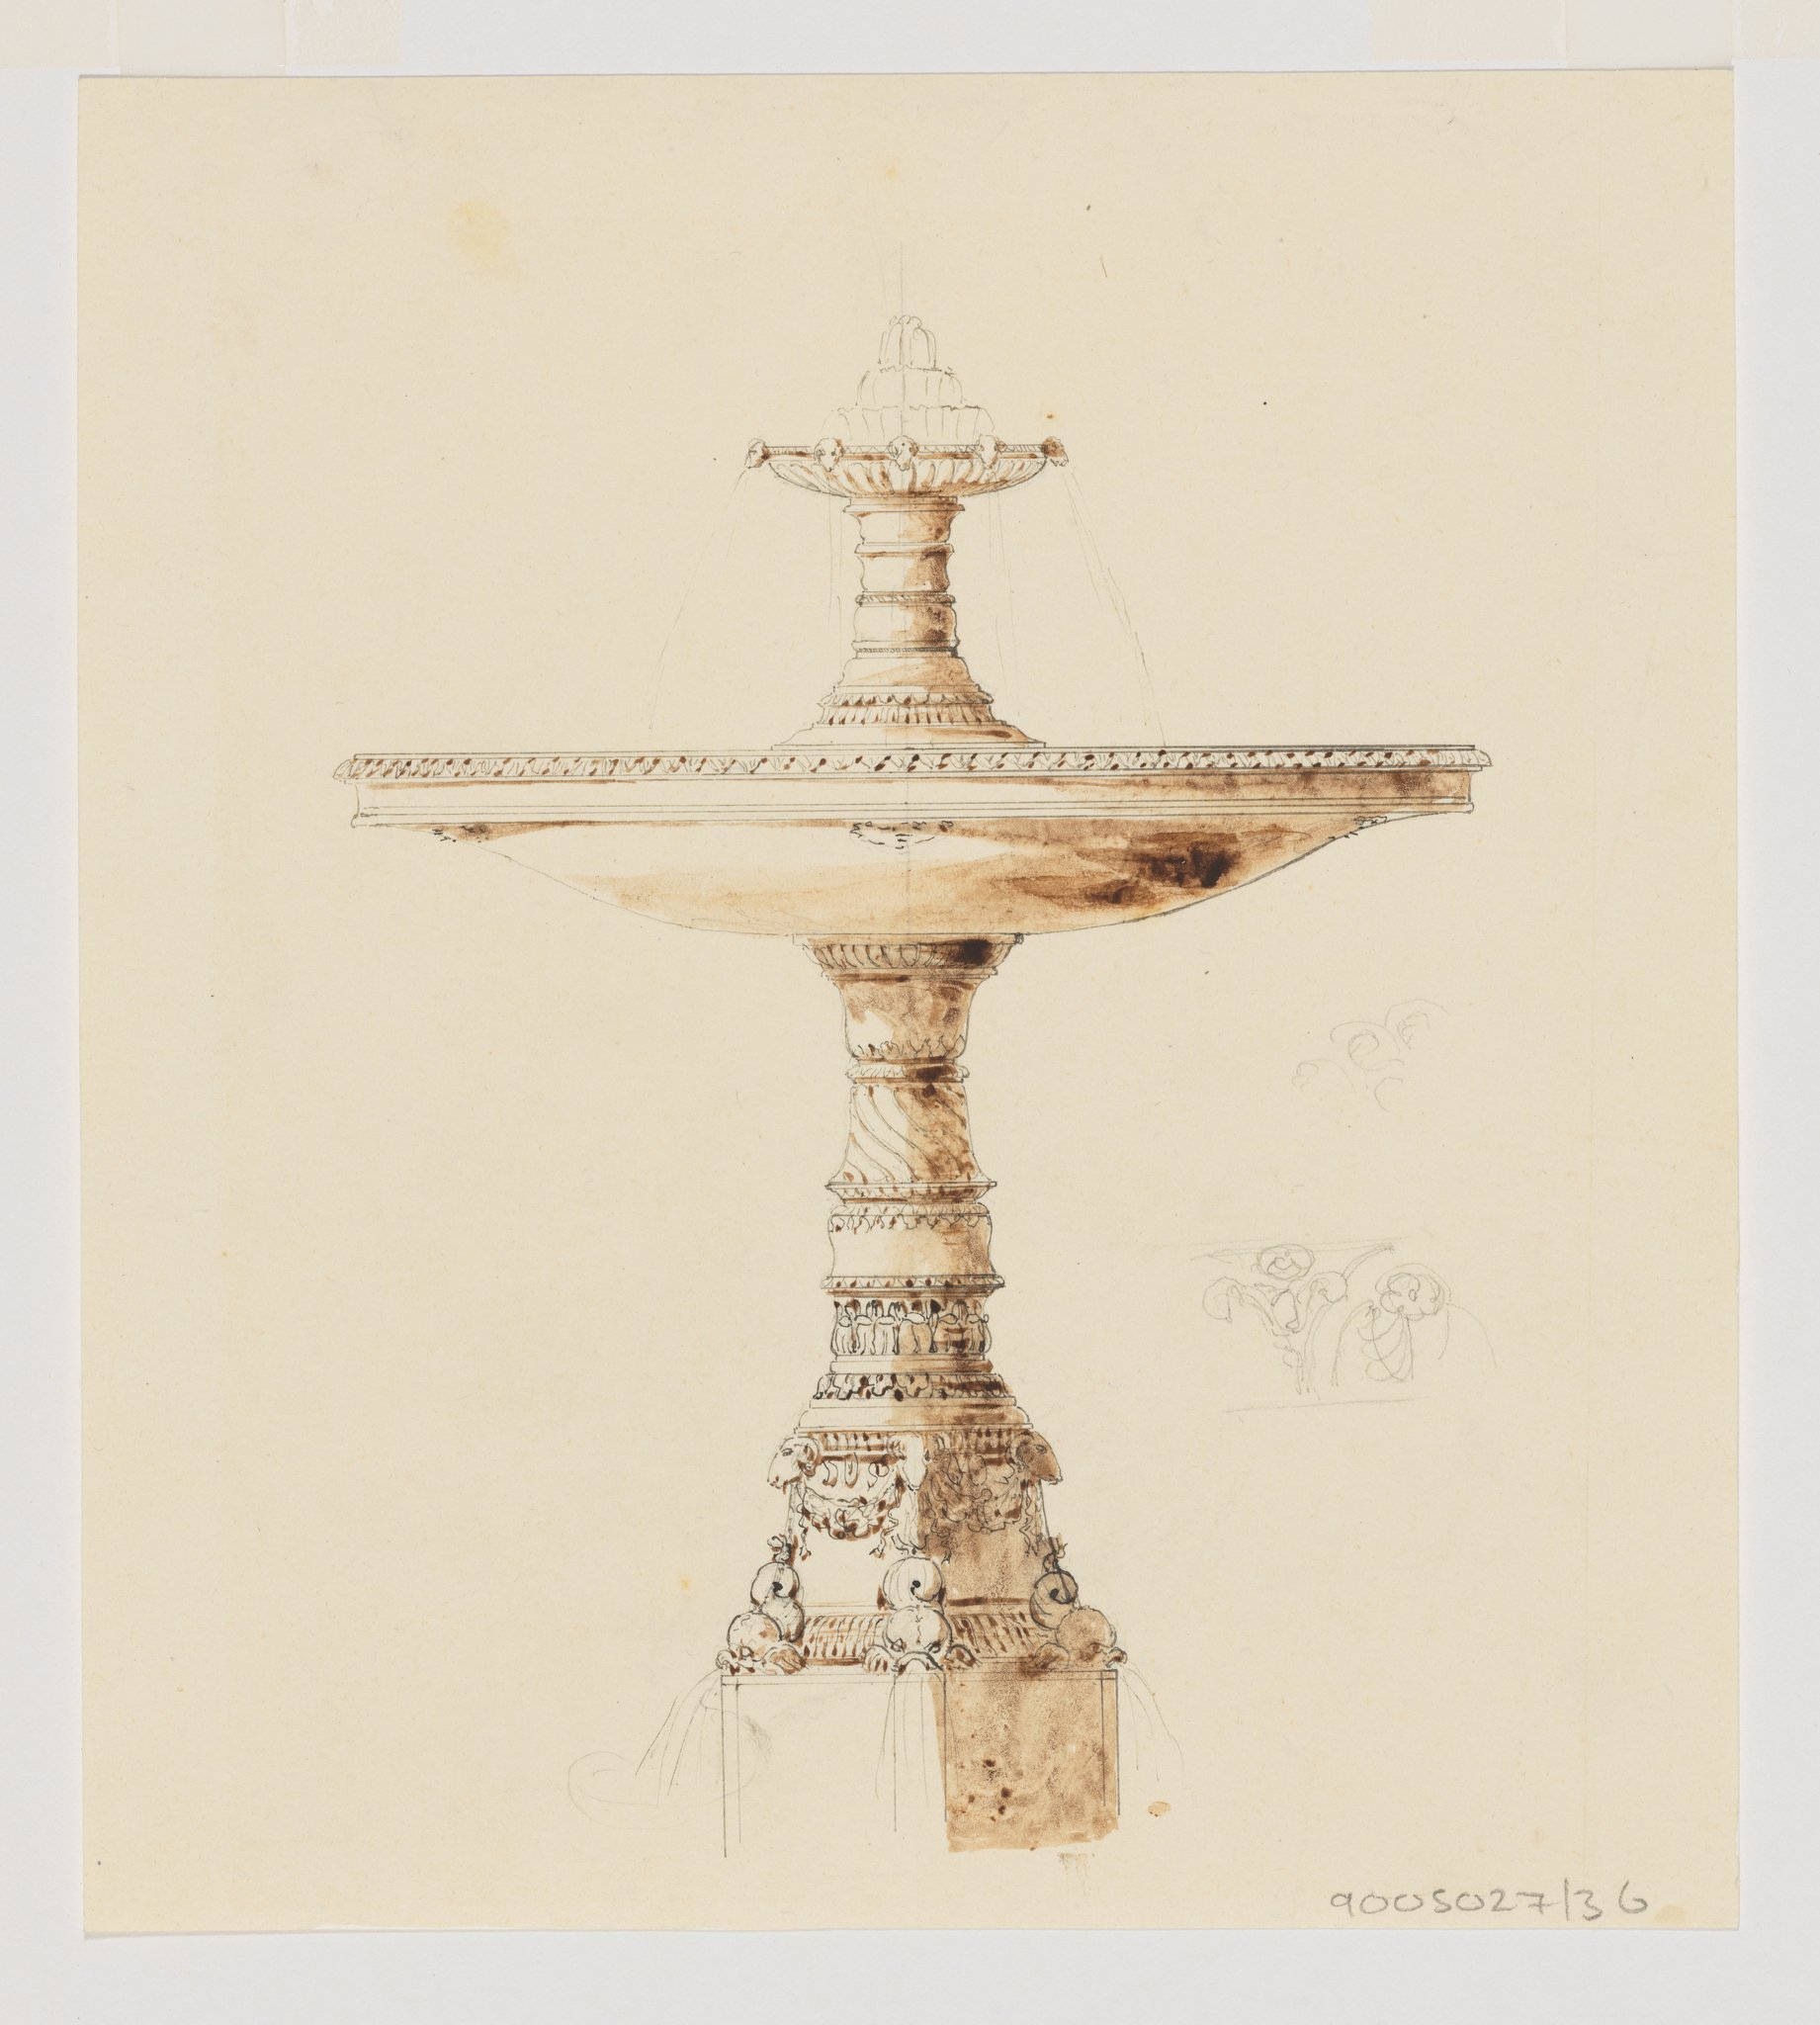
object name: drawing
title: Design for a Fountain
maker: jean-baptiste louis plantar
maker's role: artist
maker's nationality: french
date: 1834-1866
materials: graphite, ink, watercolor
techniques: pen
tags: fountains